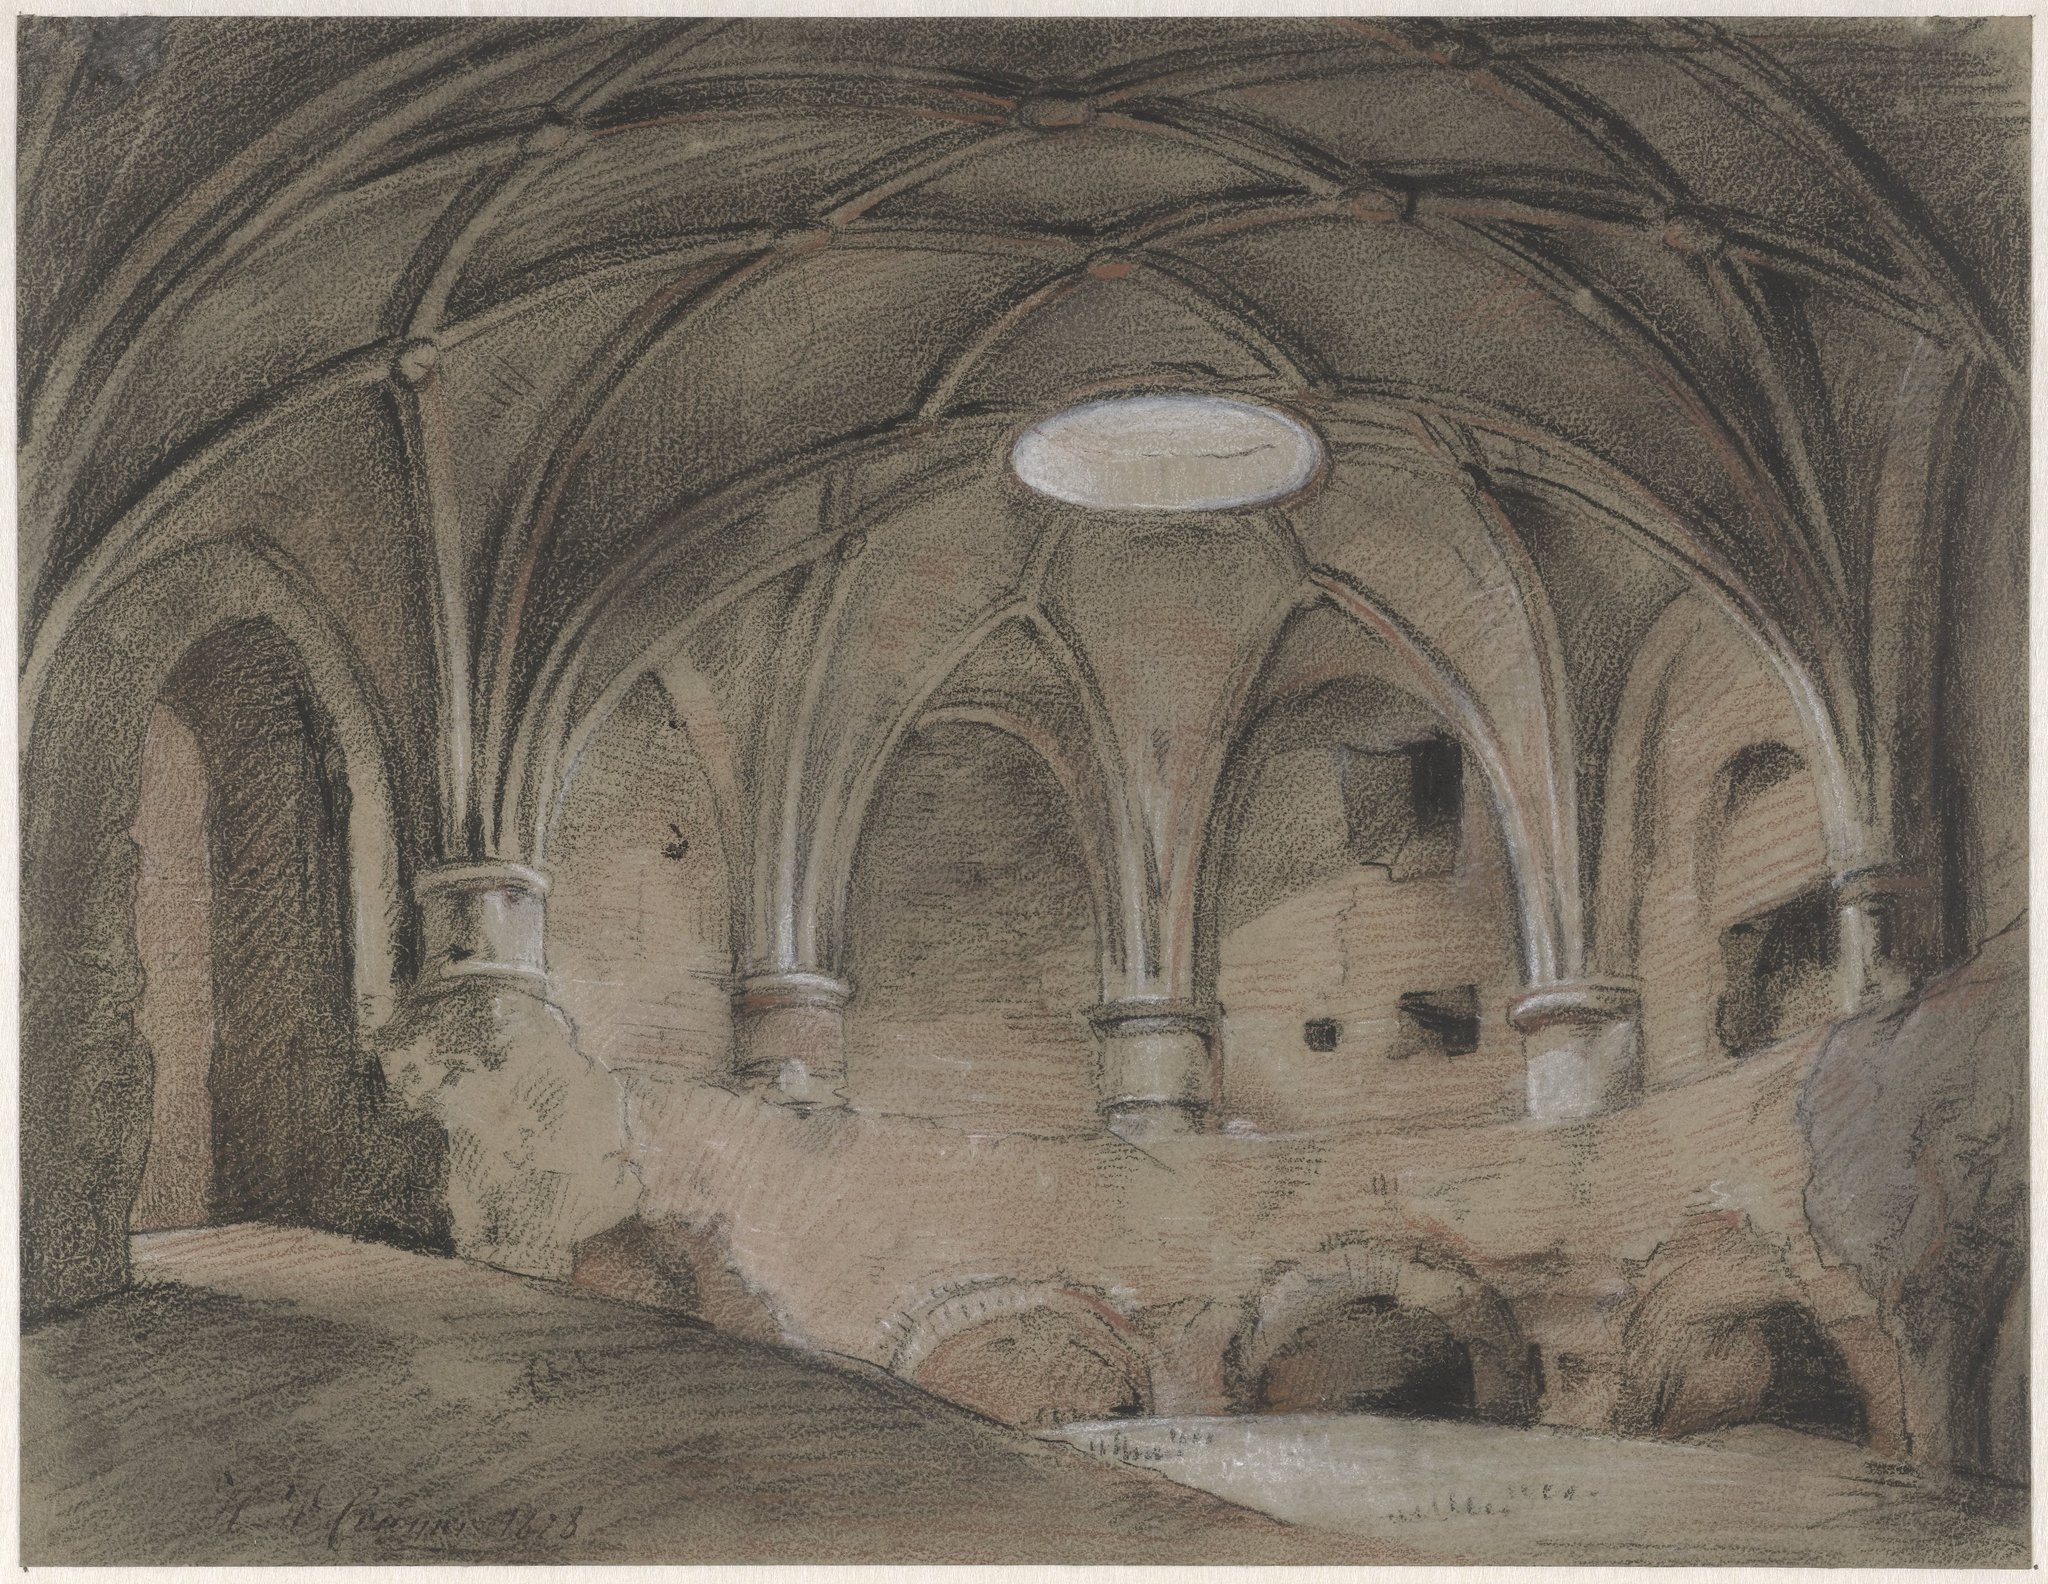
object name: drawing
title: Gedeelte van het Spanjaardshol op het Vreeburg te Utrecht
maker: hendrik willem cramer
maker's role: draughtsman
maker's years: 1809-1874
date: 1828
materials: chalk, paper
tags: interior of the house, utrecht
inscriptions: date: ‘1828’